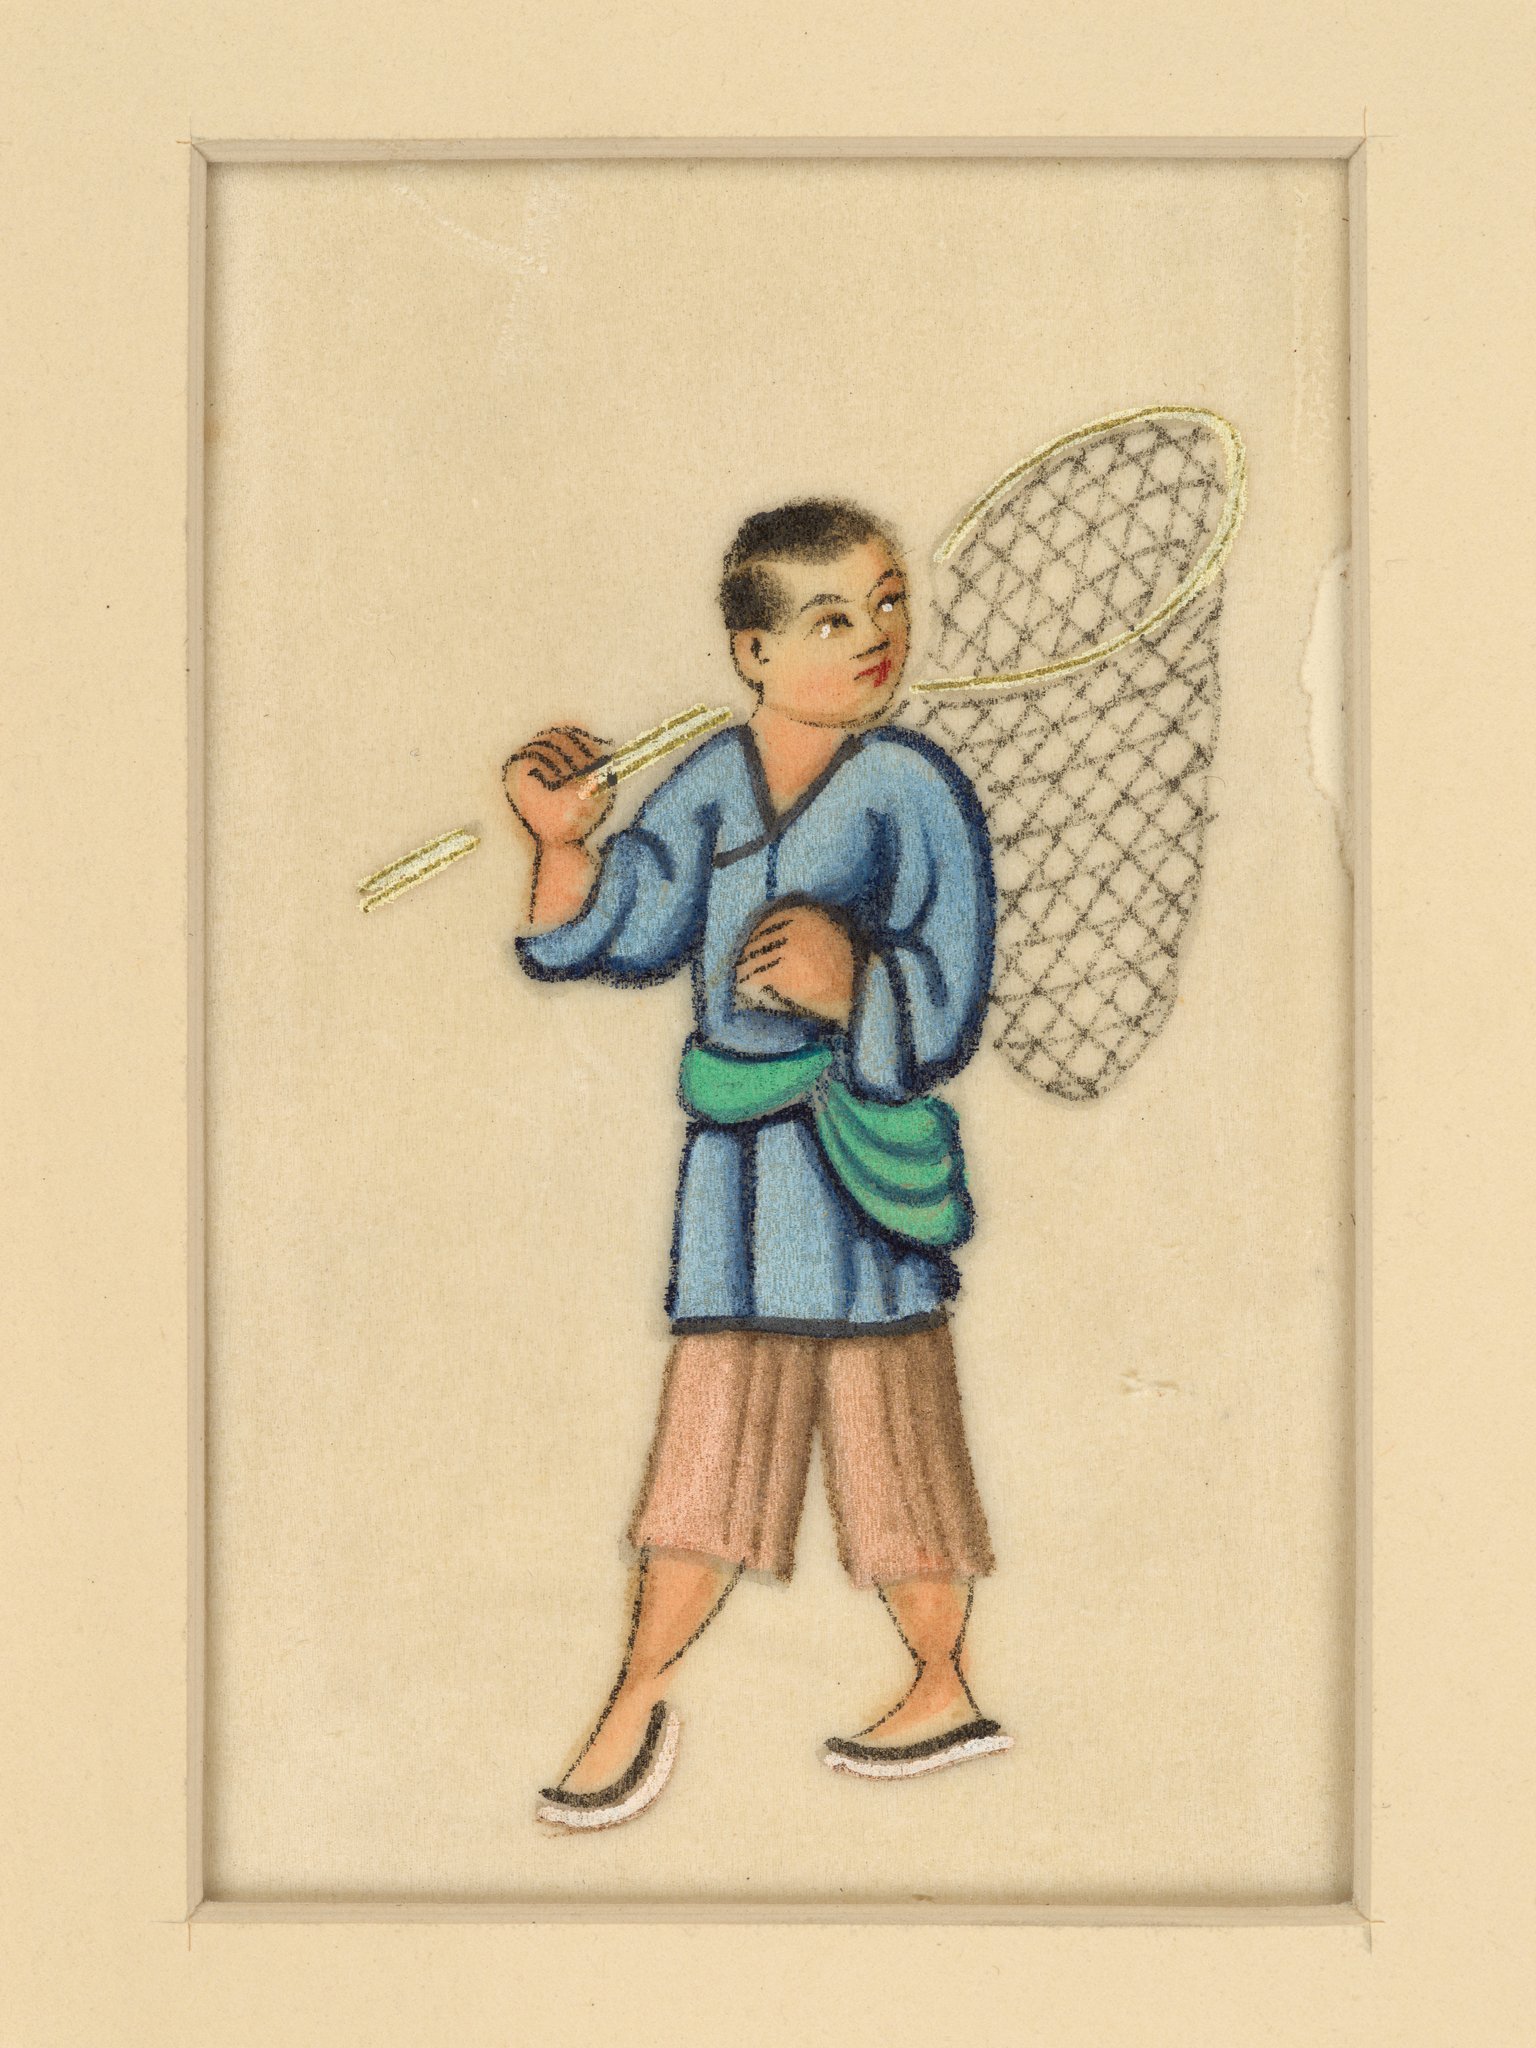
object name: leaf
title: Cake Vendor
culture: chinese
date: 1901-1933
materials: paper